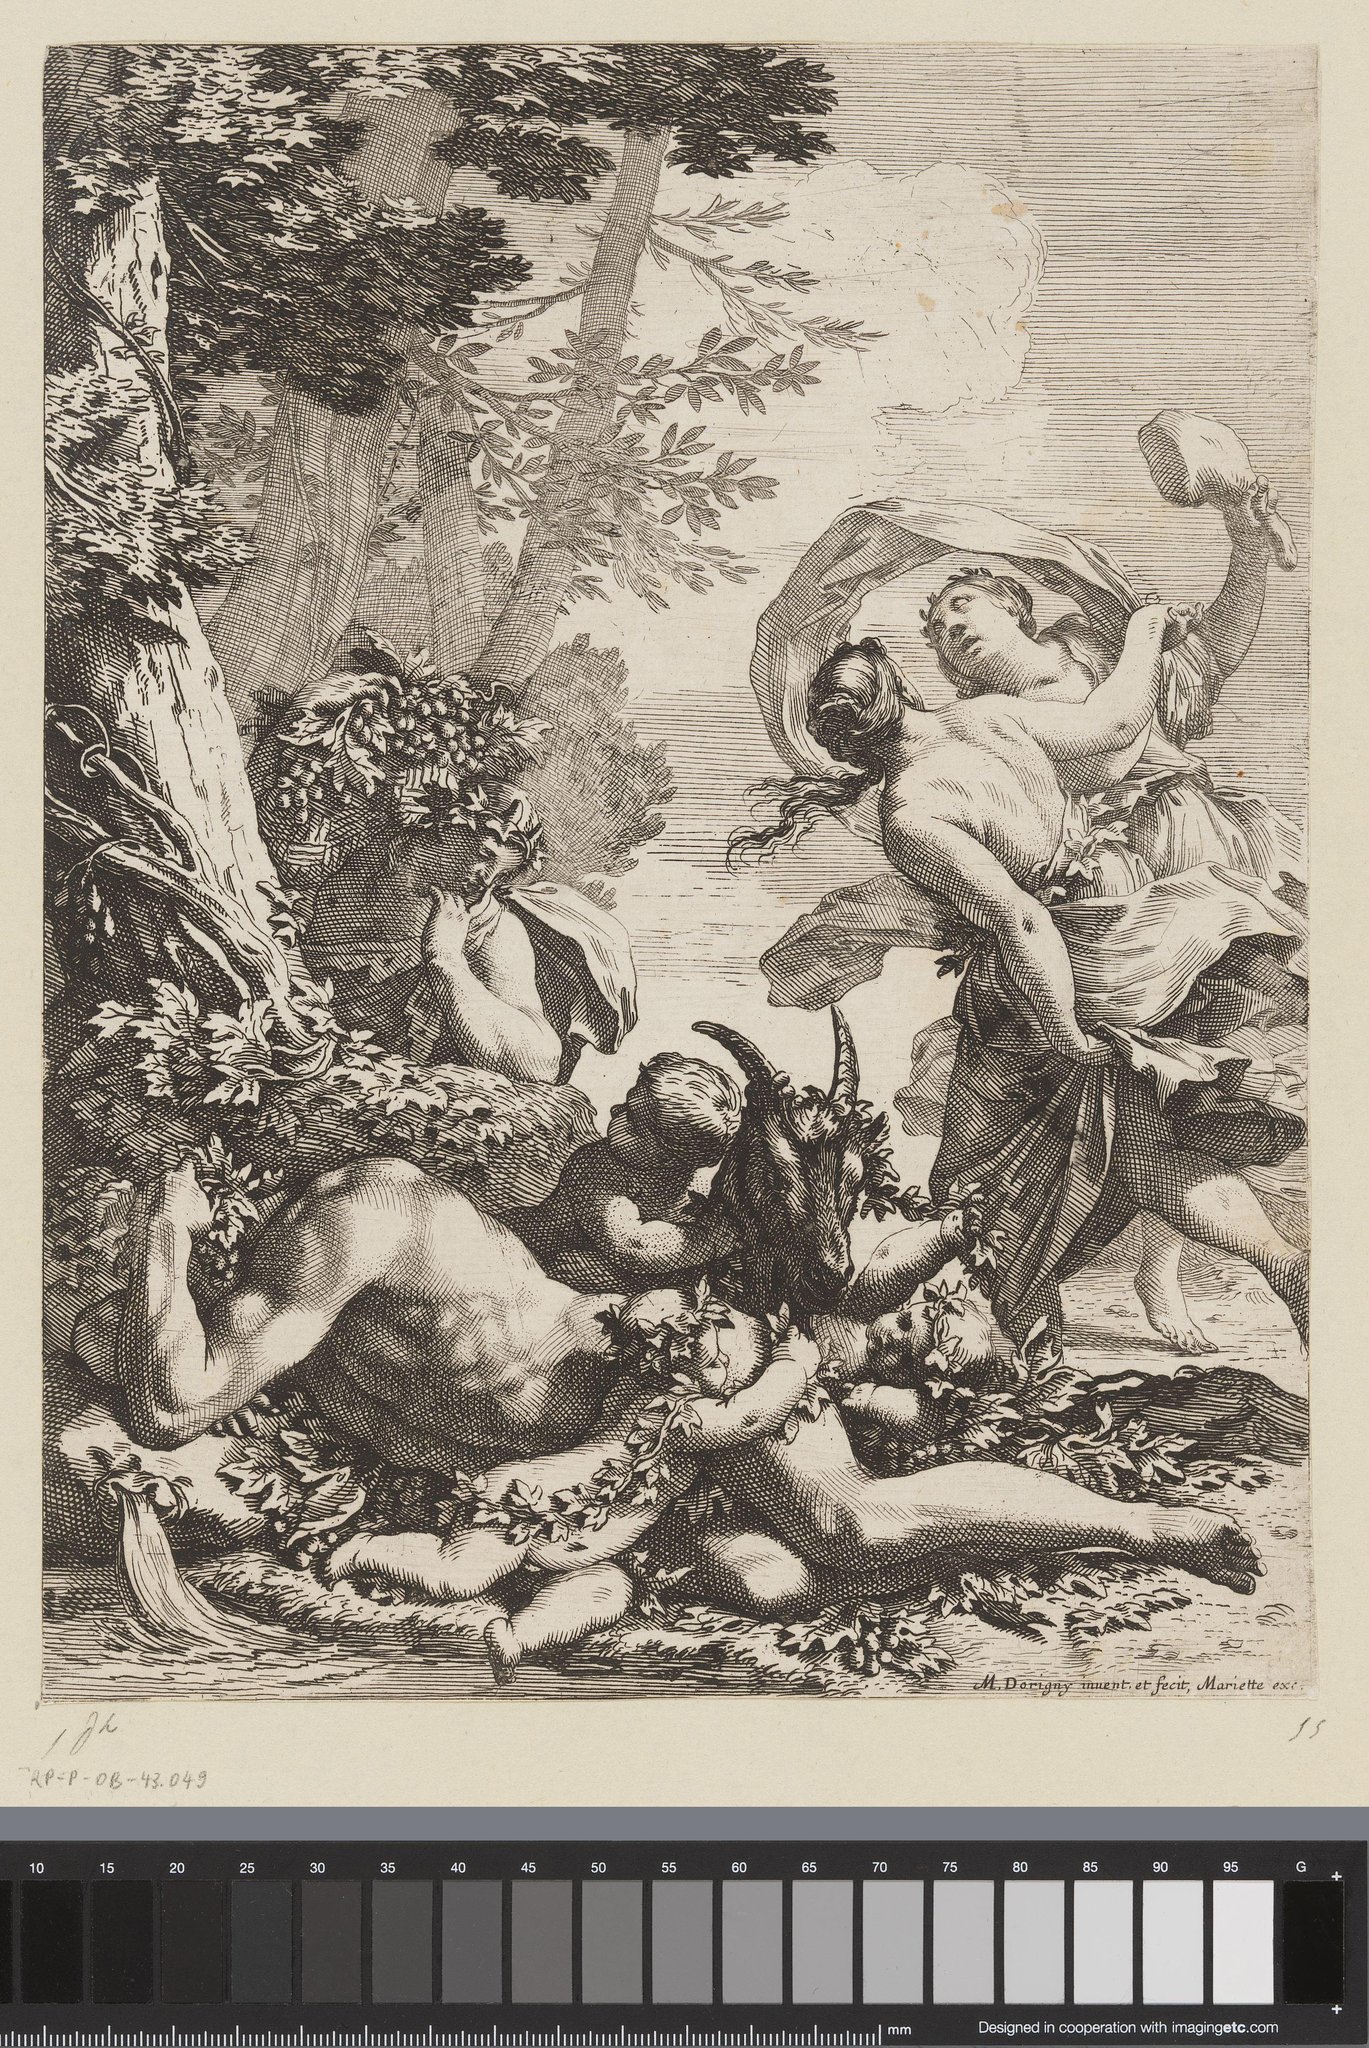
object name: print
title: Rustende bacchant met putti, geit en vrouwelijke bacchanten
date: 1626-1665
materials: paper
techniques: engraving, etching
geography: paris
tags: maenad(s), female bacchant(es), male bacchant(es), goat, cupids: 'amores', 'amoretti', 'putti', resting - bb - out of doors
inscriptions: collector's mark: Lugt 240